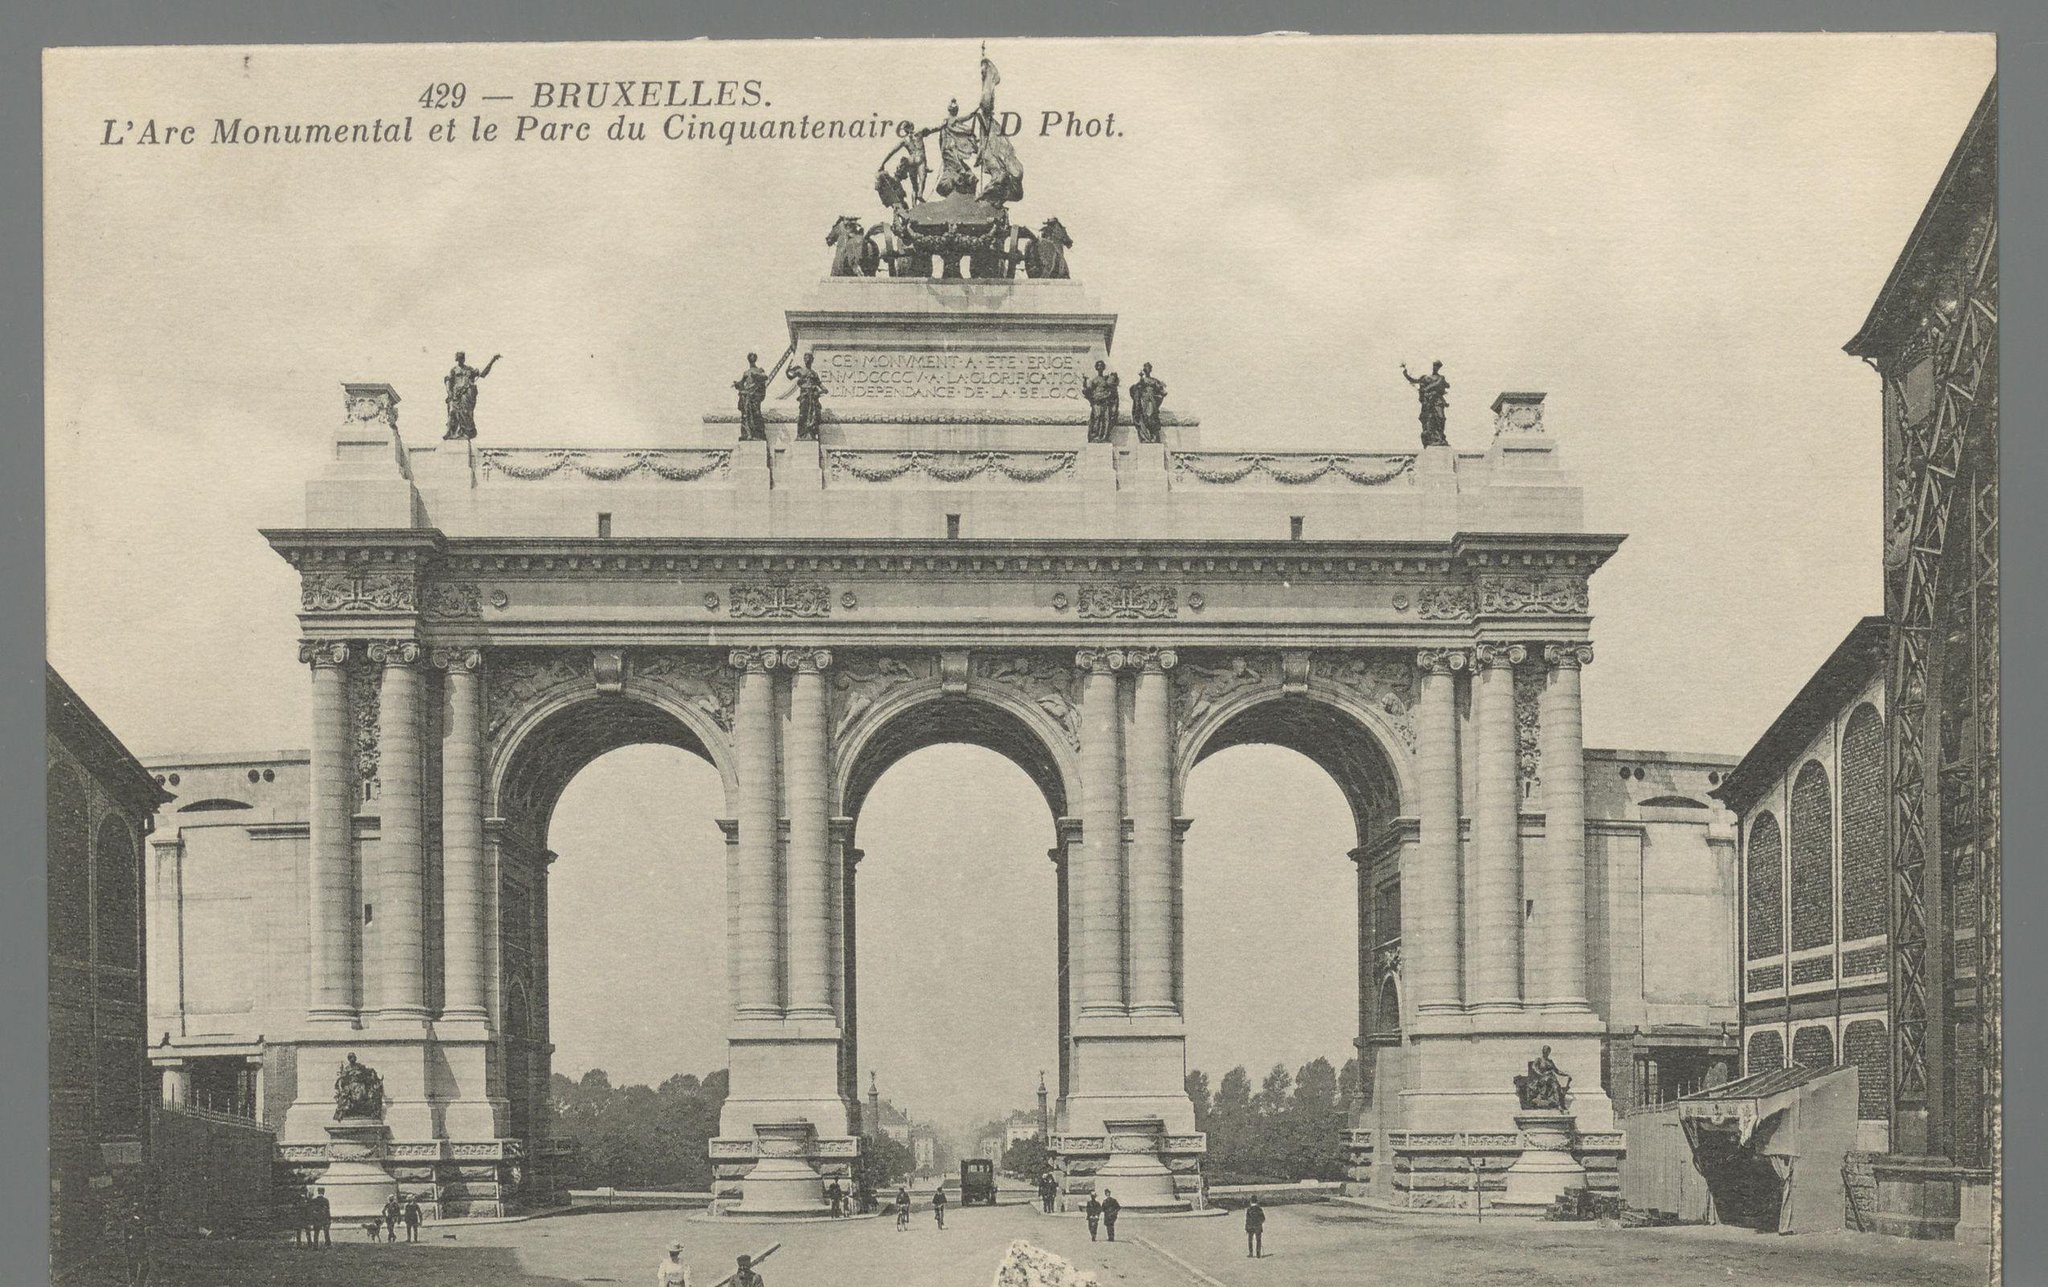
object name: ansichtkaart, prentbriefkaart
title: Bruxelles. L'Arc Monumental et le Parc du Cinquantenaire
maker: Anonymous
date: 1906-1918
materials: cardboard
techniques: photograph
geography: brussels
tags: public gardens, park (+ city(-scape) with figures, staffage), gate, entrance, monument, statue